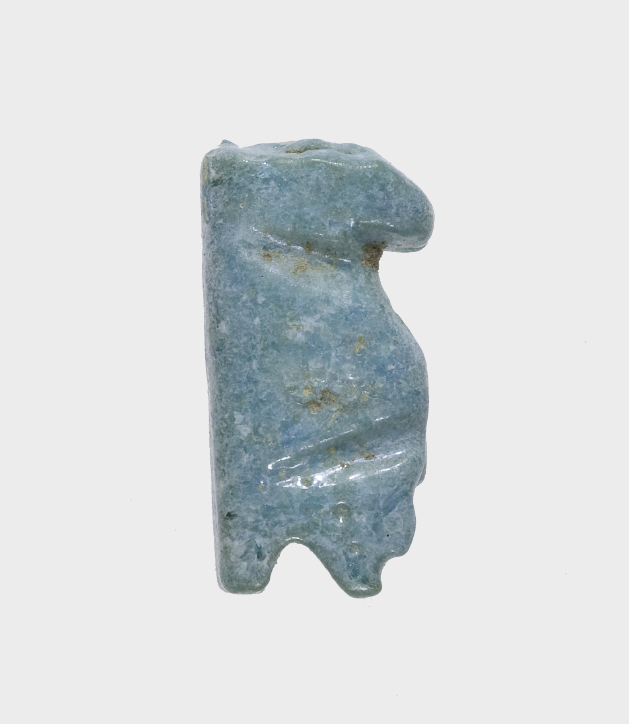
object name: amulet, taweret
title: Taweret (?) Amulet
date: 1802-1450 BCE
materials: faience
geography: egypt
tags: taweret